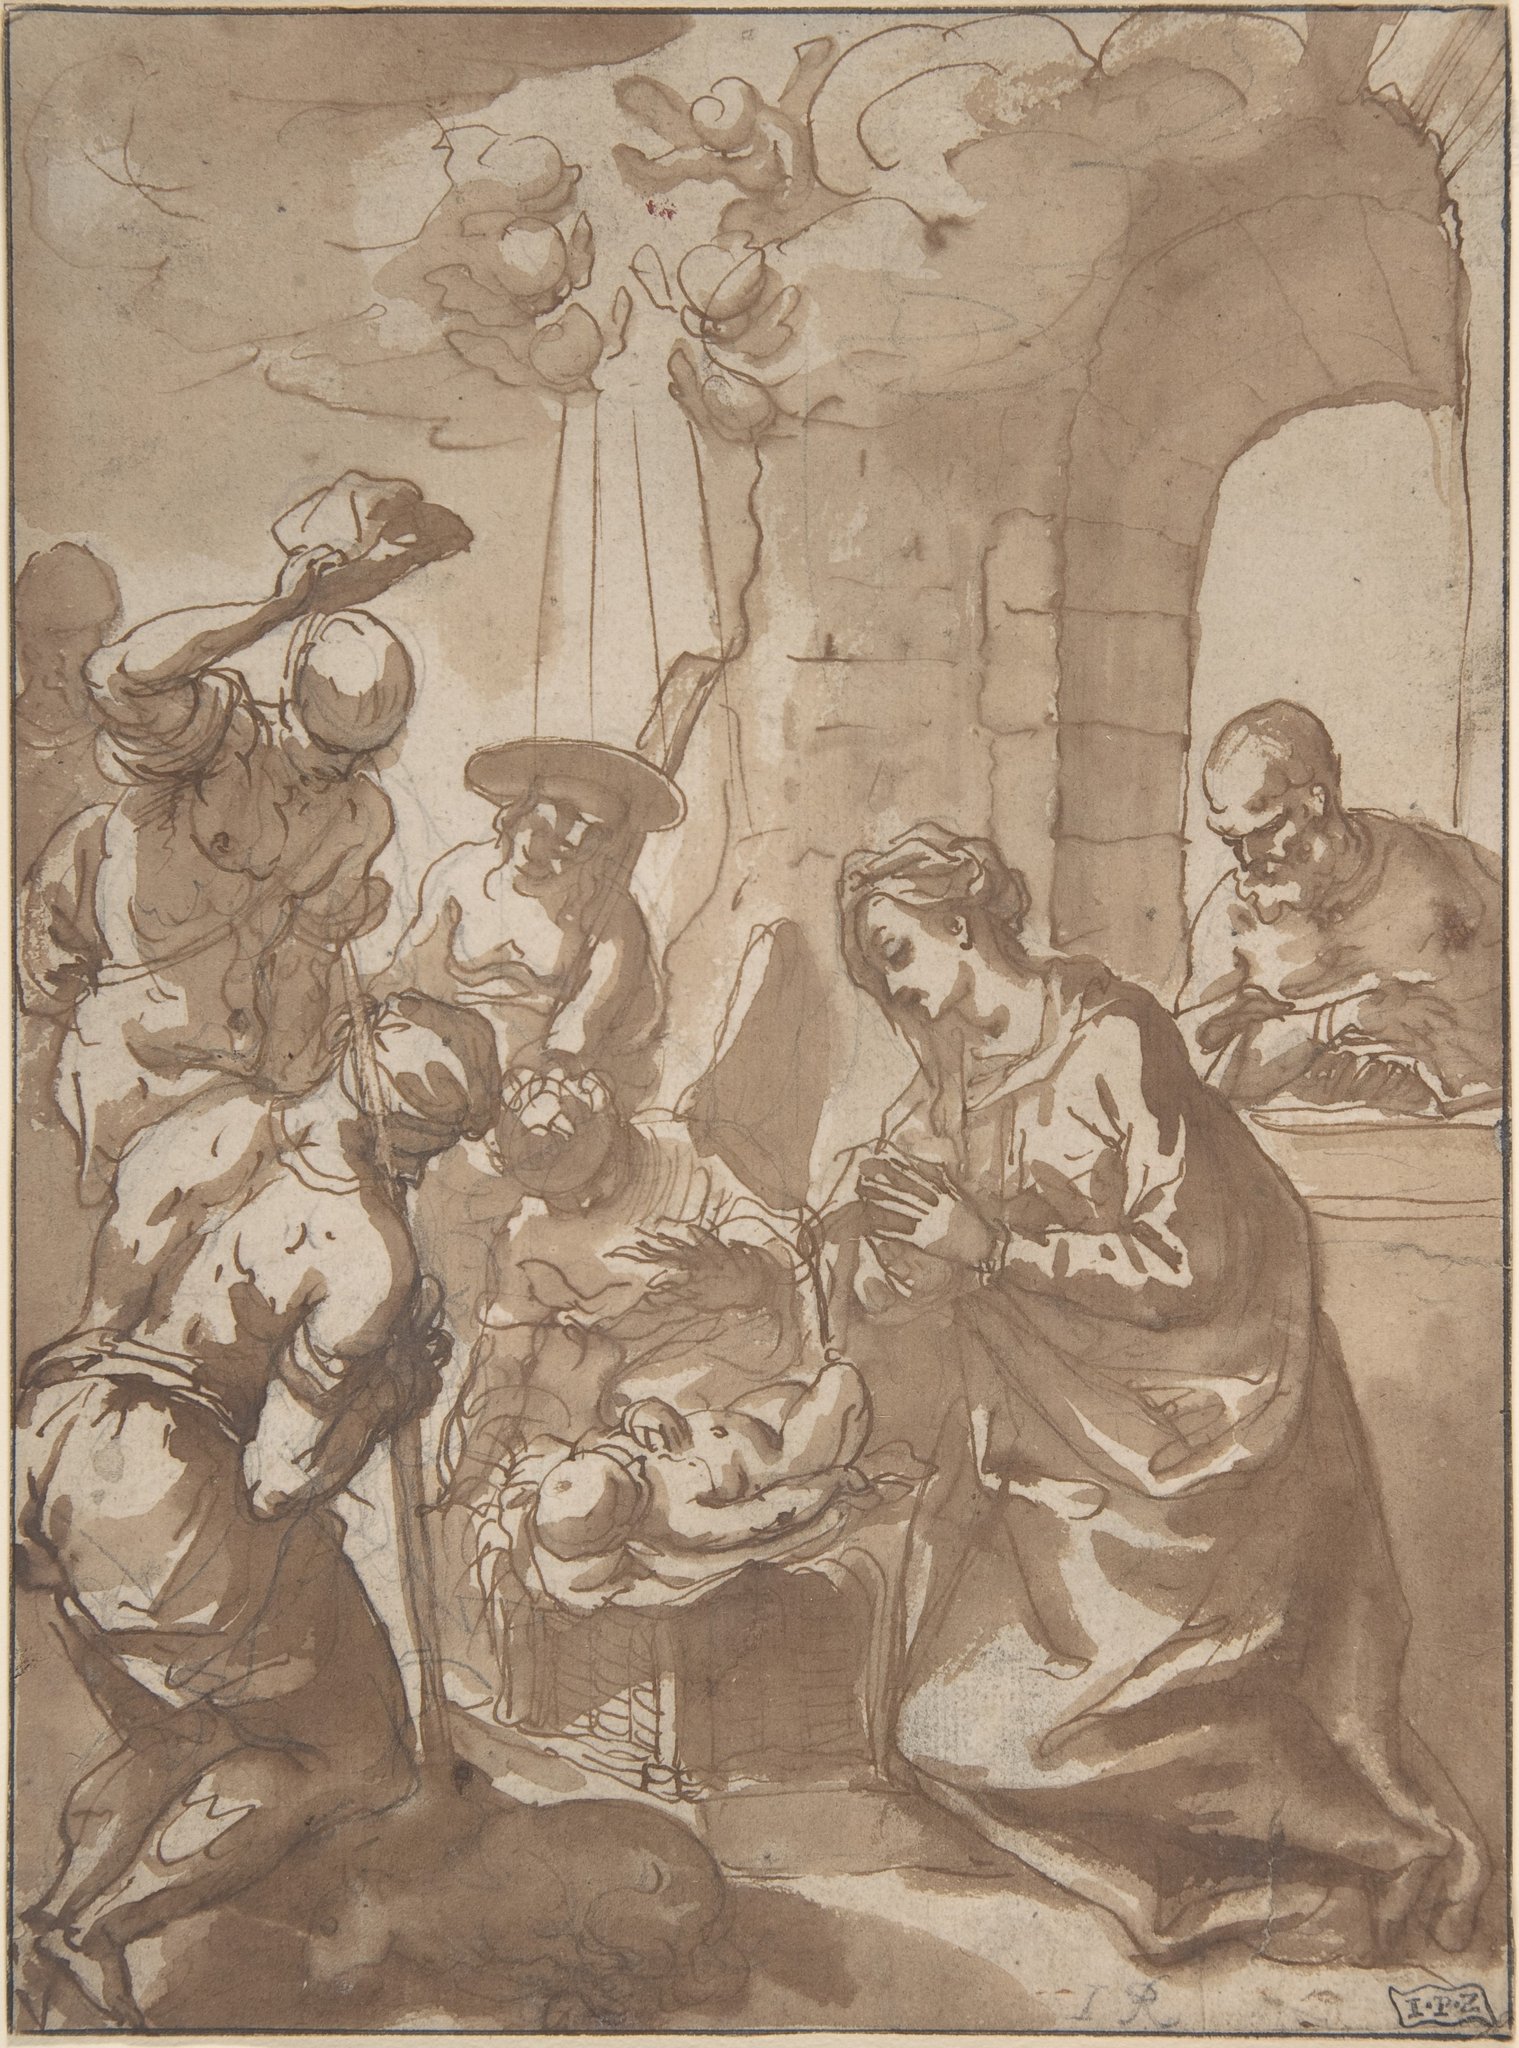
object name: drawing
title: The Adoration of the Shepherds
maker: hans rottenhammer i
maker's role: artist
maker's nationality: german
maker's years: 1564-1625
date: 1595-1606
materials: chalk, ink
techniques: pen, wash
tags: infants,men,women,shepherds